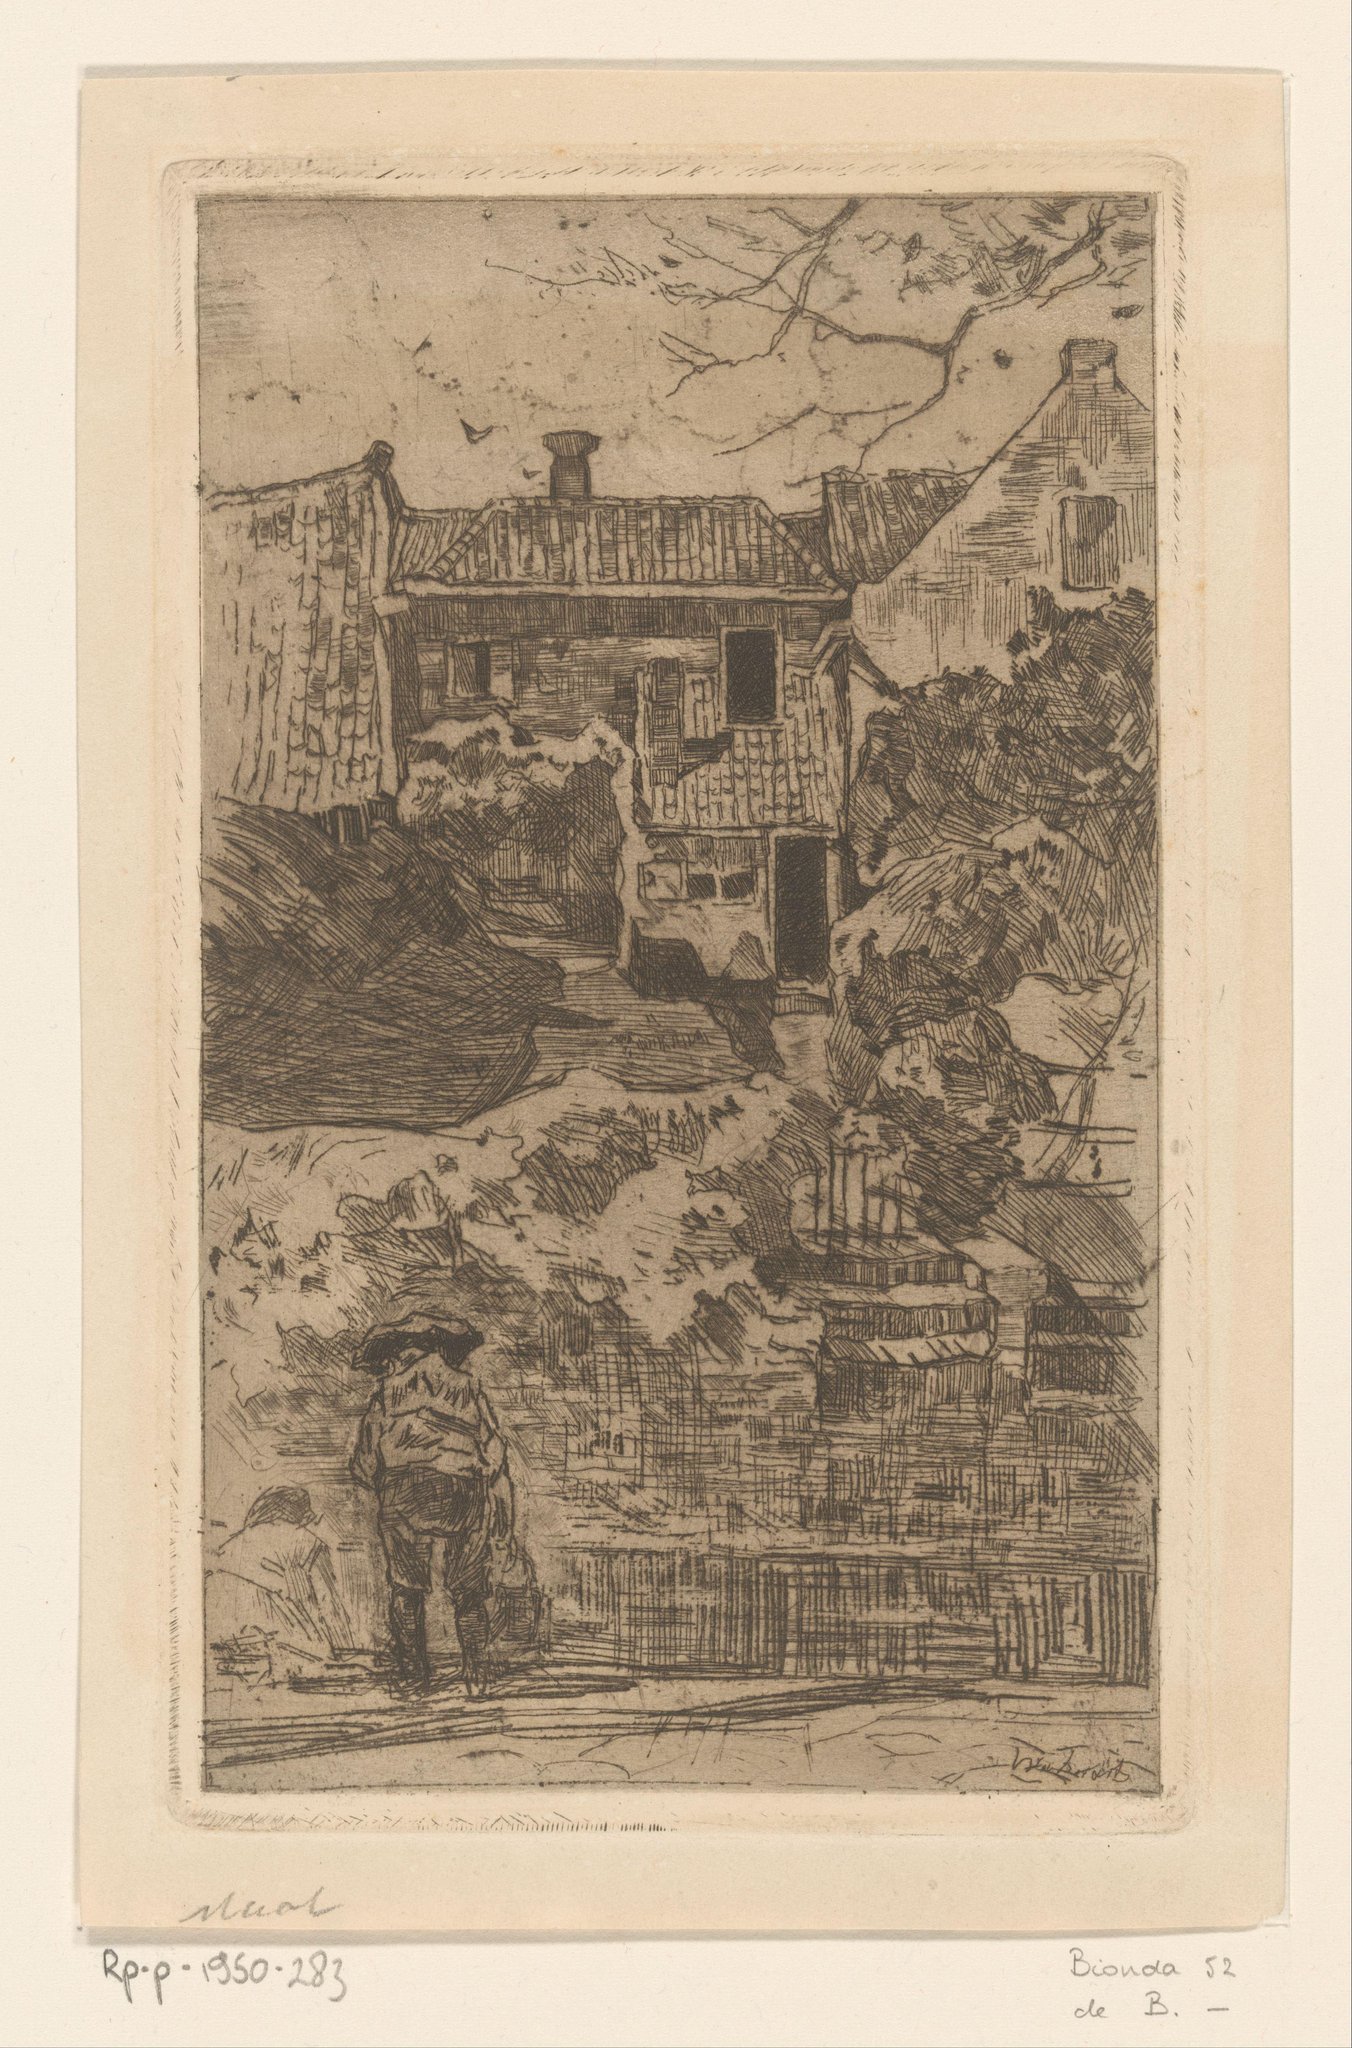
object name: print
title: Spelende kinderen aan het water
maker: willem de zwart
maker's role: draughtsman, painter, print maker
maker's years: 1862-1931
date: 1895-1896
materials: paper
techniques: drypoint, etching, intaglio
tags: children's games and plays, pond, pool, civic architecture; edifices; dwellings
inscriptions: collector's mark: Lugt 2228